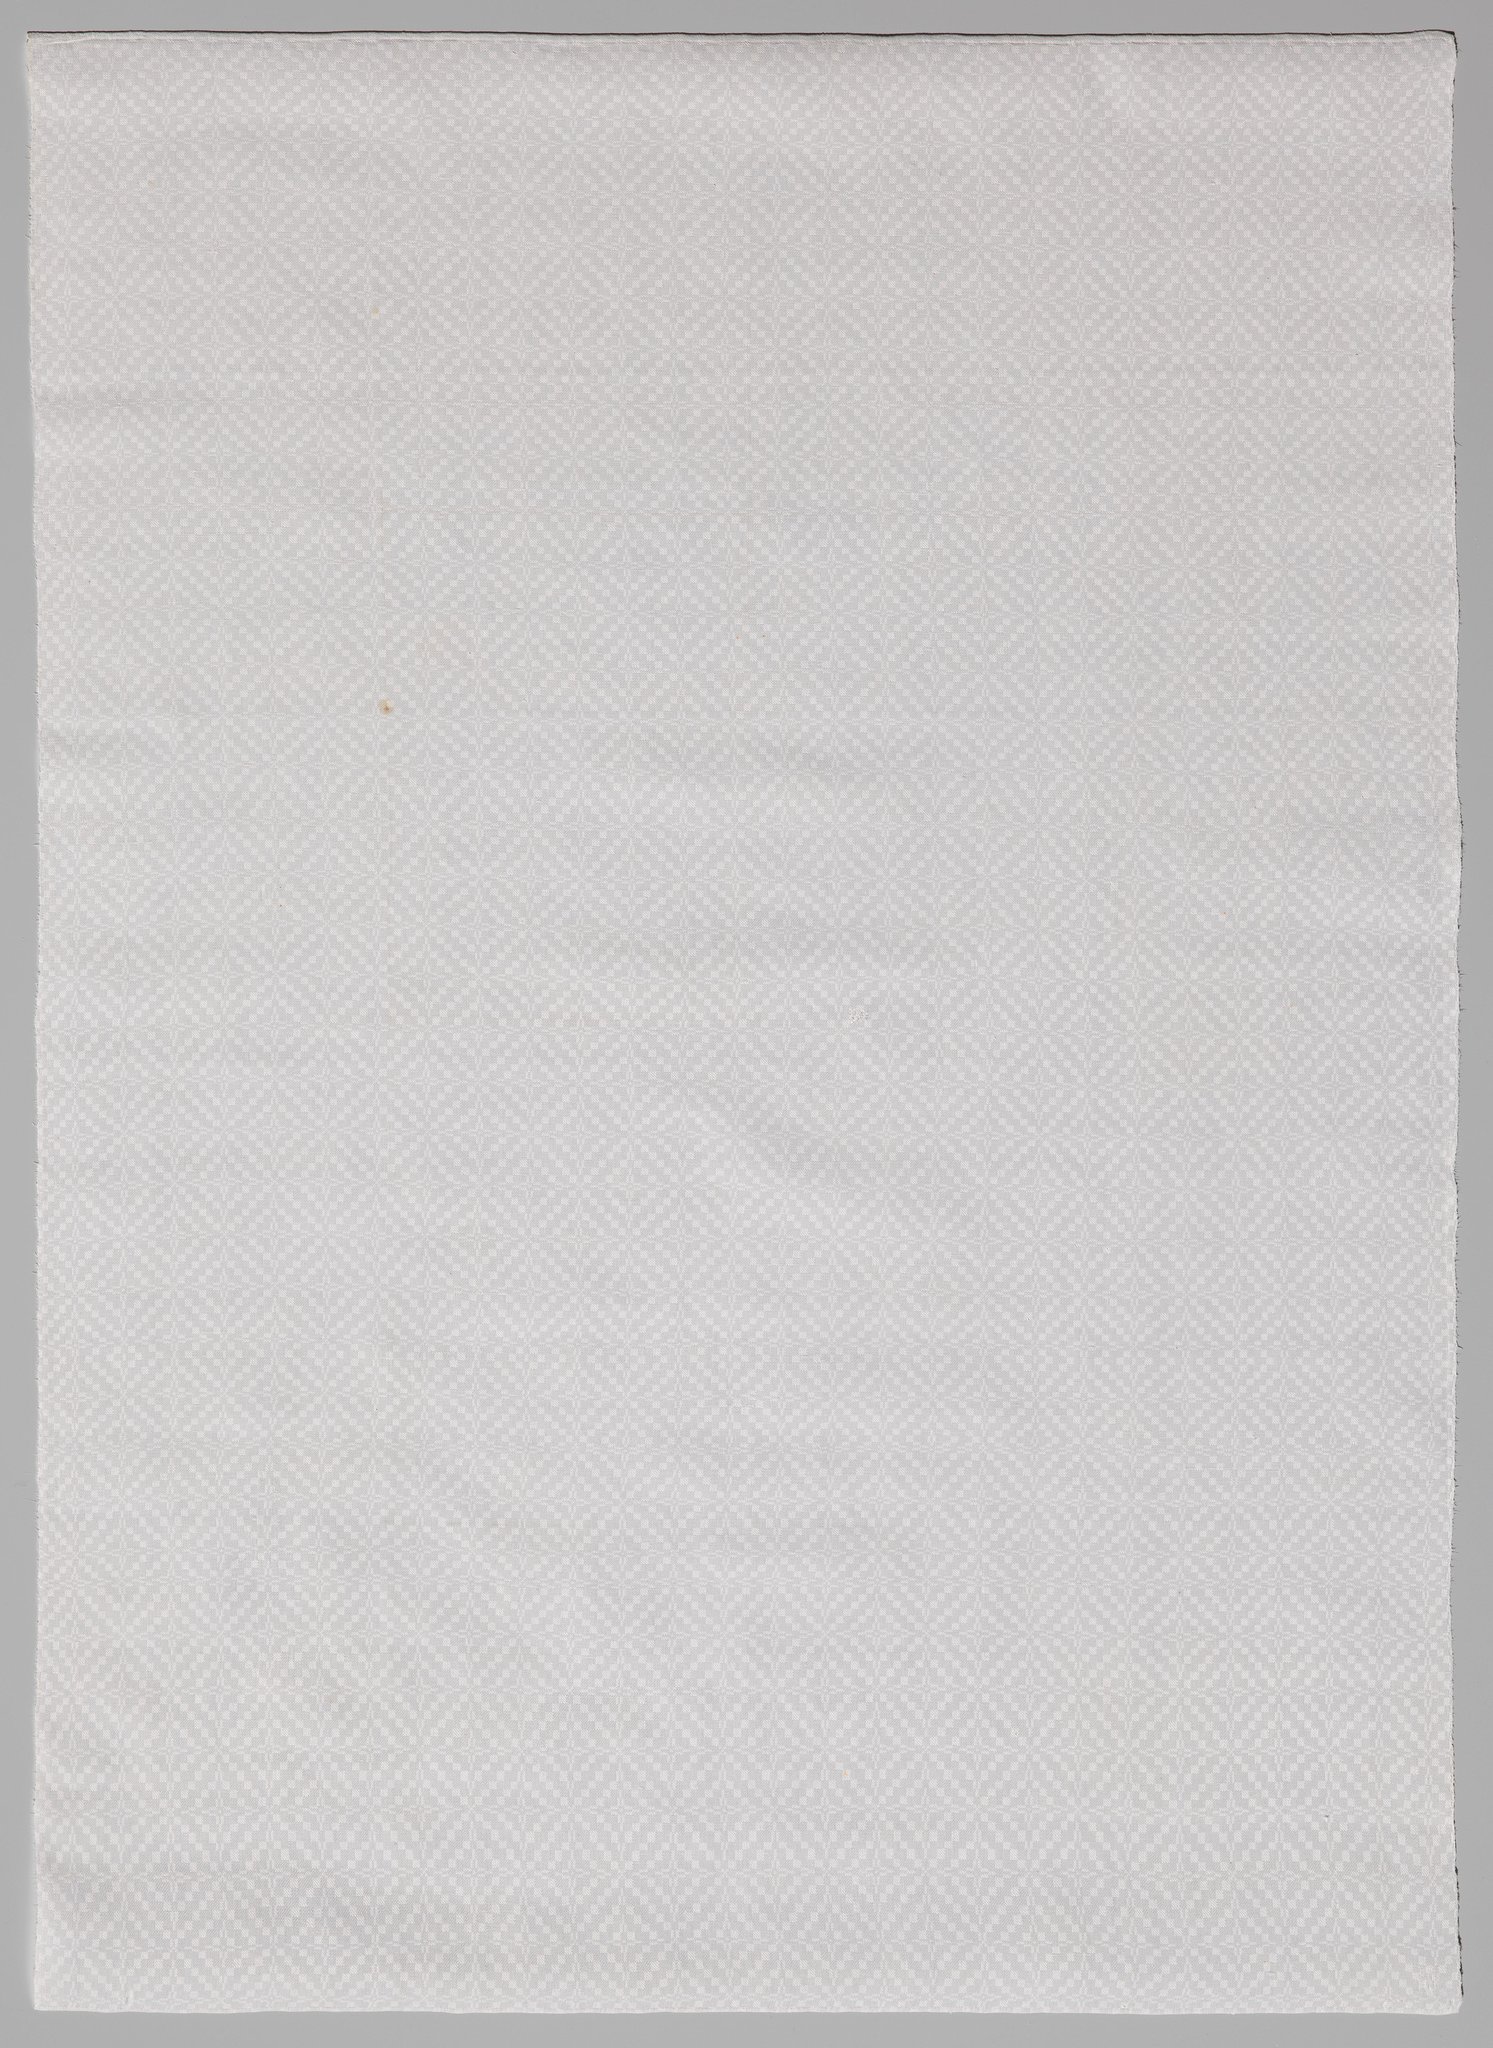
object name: napkin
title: Pellenpatroon, z.g. "molenwiek". Merk: CH 24.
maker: Anonymous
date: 1600-1675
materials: linen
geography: northern netherlands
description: Servet van wit linnen met een pellen patroon in keper z.g. 'molenwiek', merk CH 24.